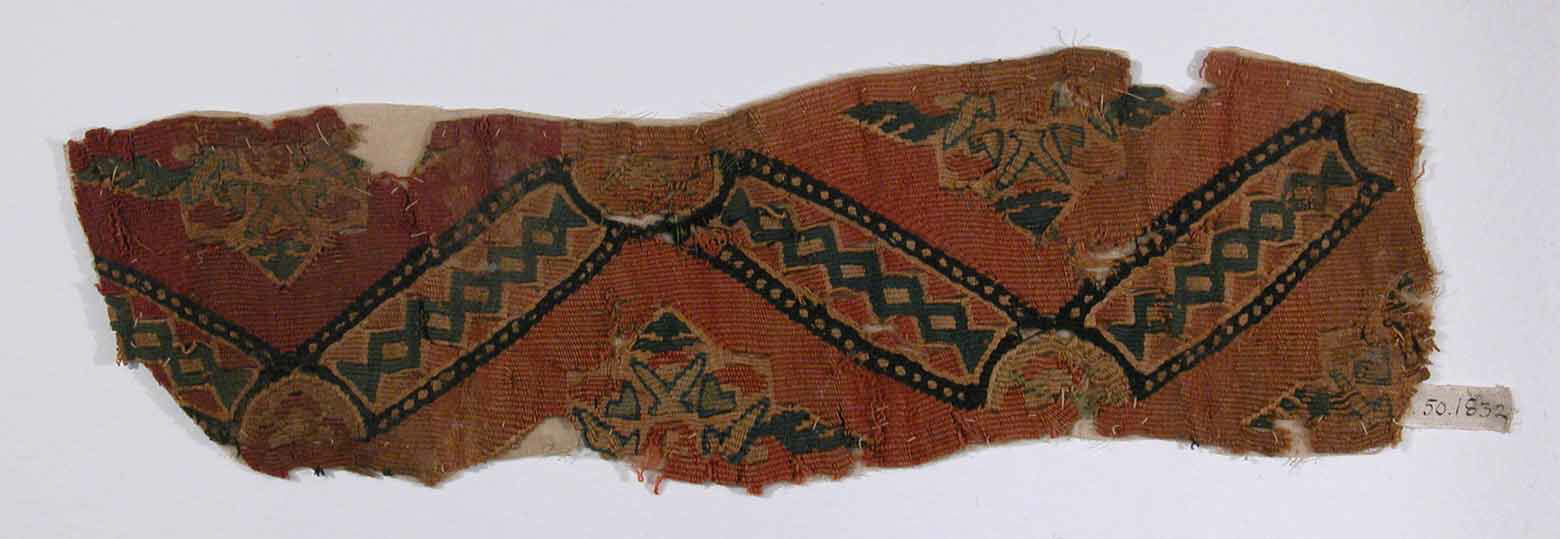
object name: textile fragment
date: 501-700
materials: linen, wool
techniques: weave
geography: egypt